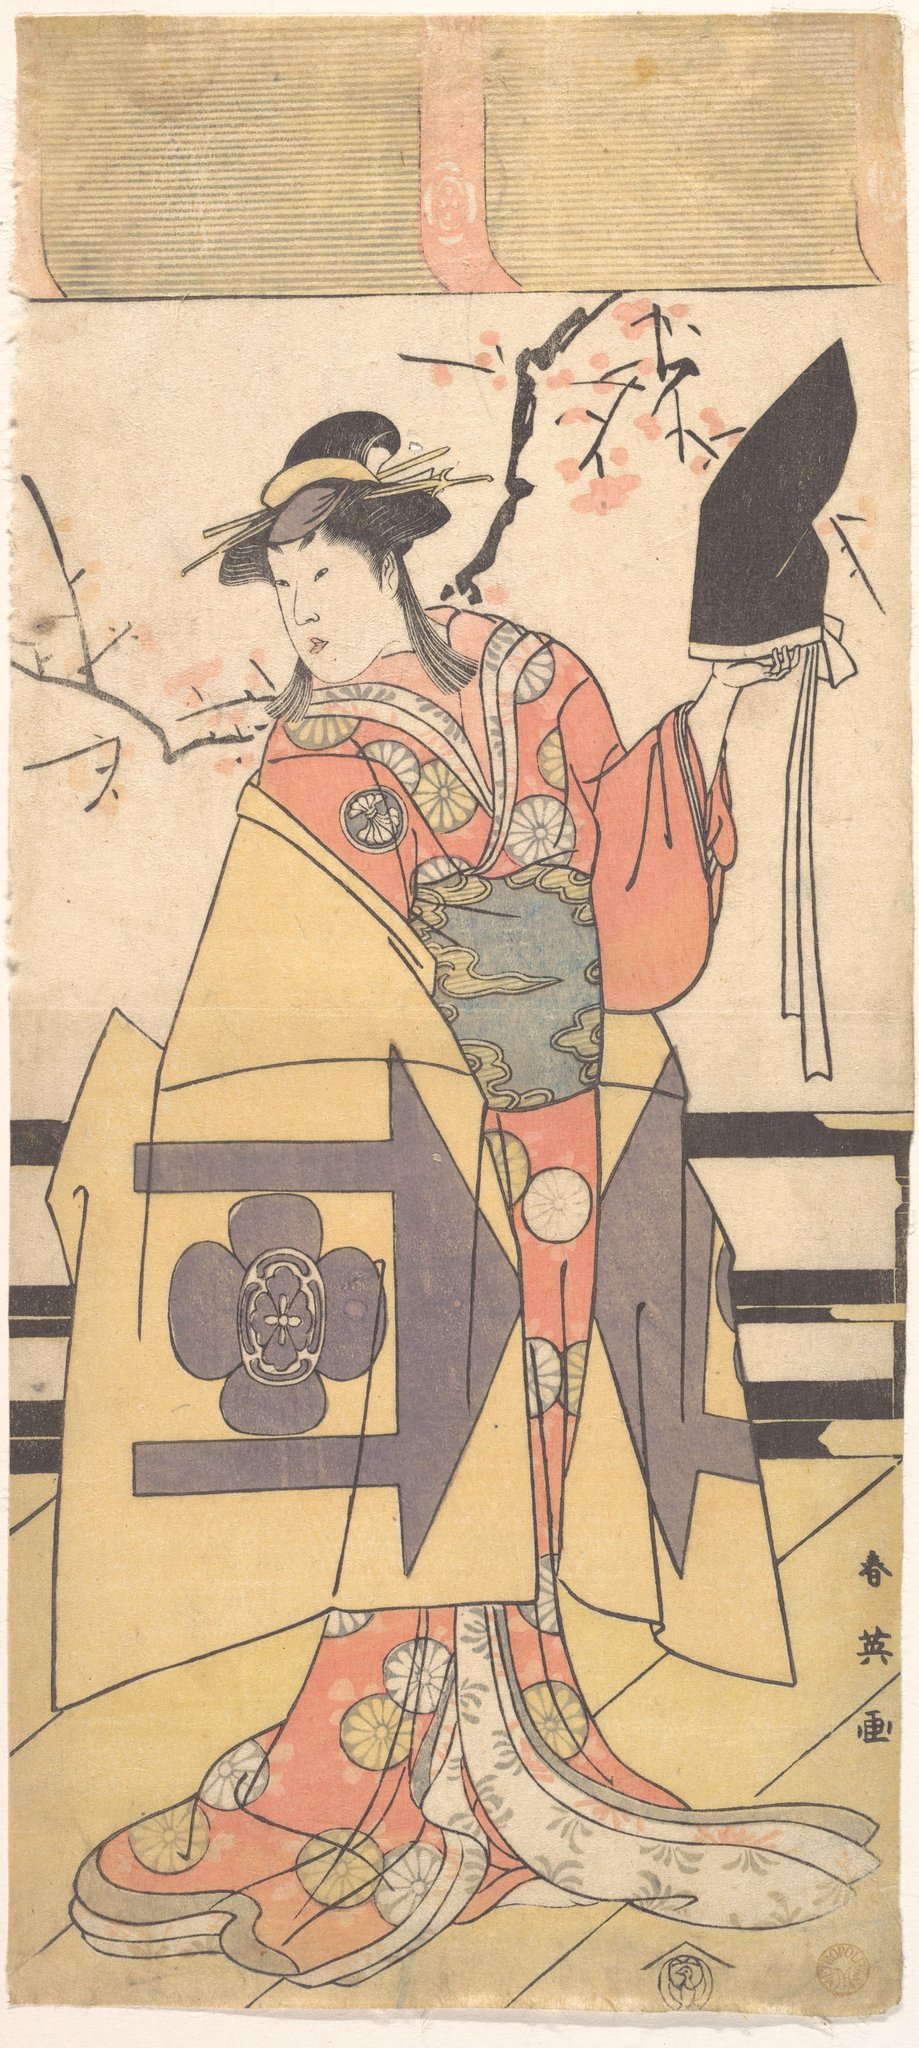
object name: print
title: The Third Segawa Kikunojo as (?) Wife of Kudo Suketsune in a Soga Play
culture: japanese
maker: katsukawa shun'ei 勝川春英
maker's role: artist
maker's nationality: japanese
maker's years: 1762-1819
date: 1792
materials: ink, paper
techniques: woodblock print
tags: women,actors